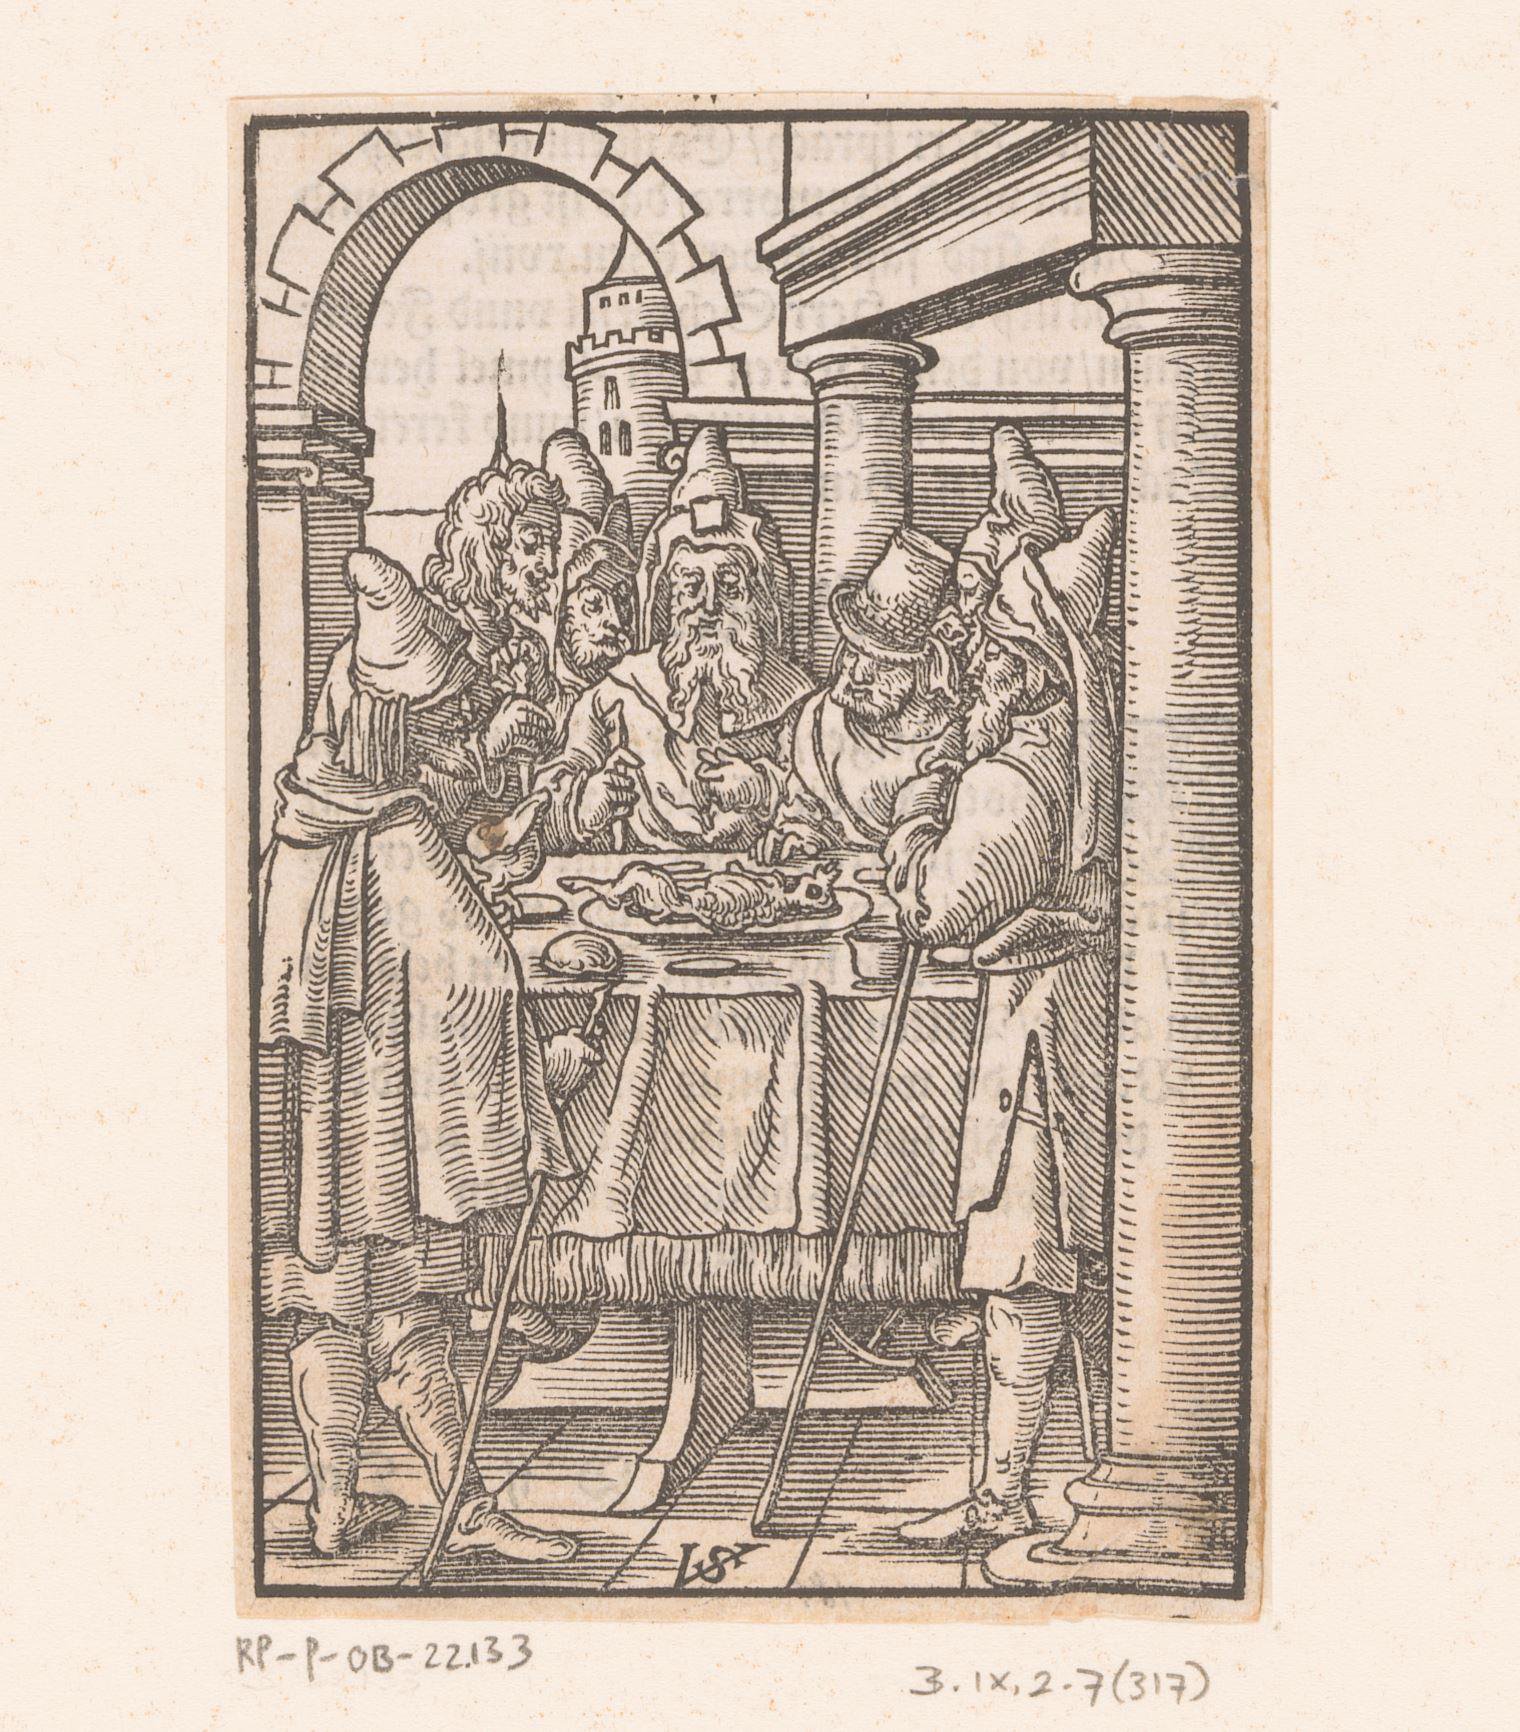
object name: print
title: Pascha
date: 1552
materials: paper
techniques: woodcut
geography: nuremberg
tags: the israelites eat the passover lamb standing about a table with their loins girt, their shoes on their feet and with staves in their hands, ready to depart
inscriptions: number: ‘181’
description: Gebruikt voor verschillende publicaties die werden gedrukt door Valentin Geißler tussen 1552 en 1560 te Neurenberg.